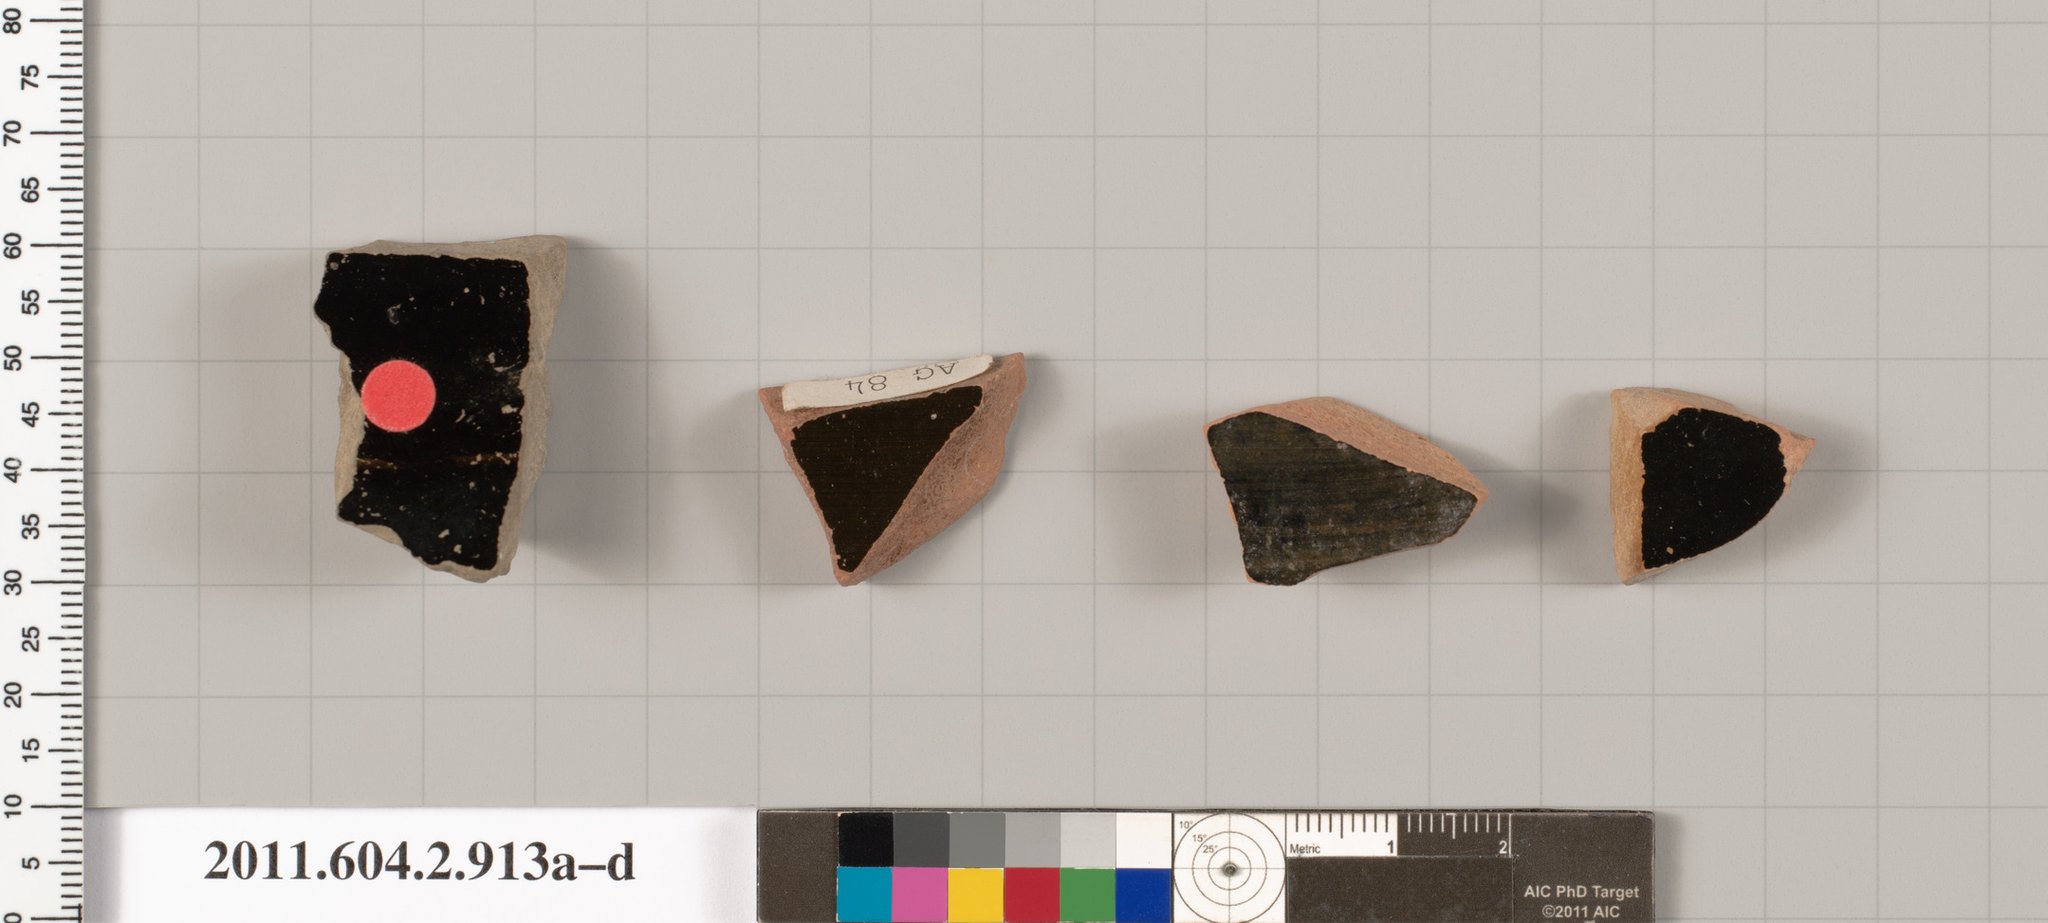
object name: bell krater fragment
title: Terracotta fragments of bell-kraters (bowls for mixing wine and water)?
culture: greek, attic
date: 450-401 BCE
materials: terracotta